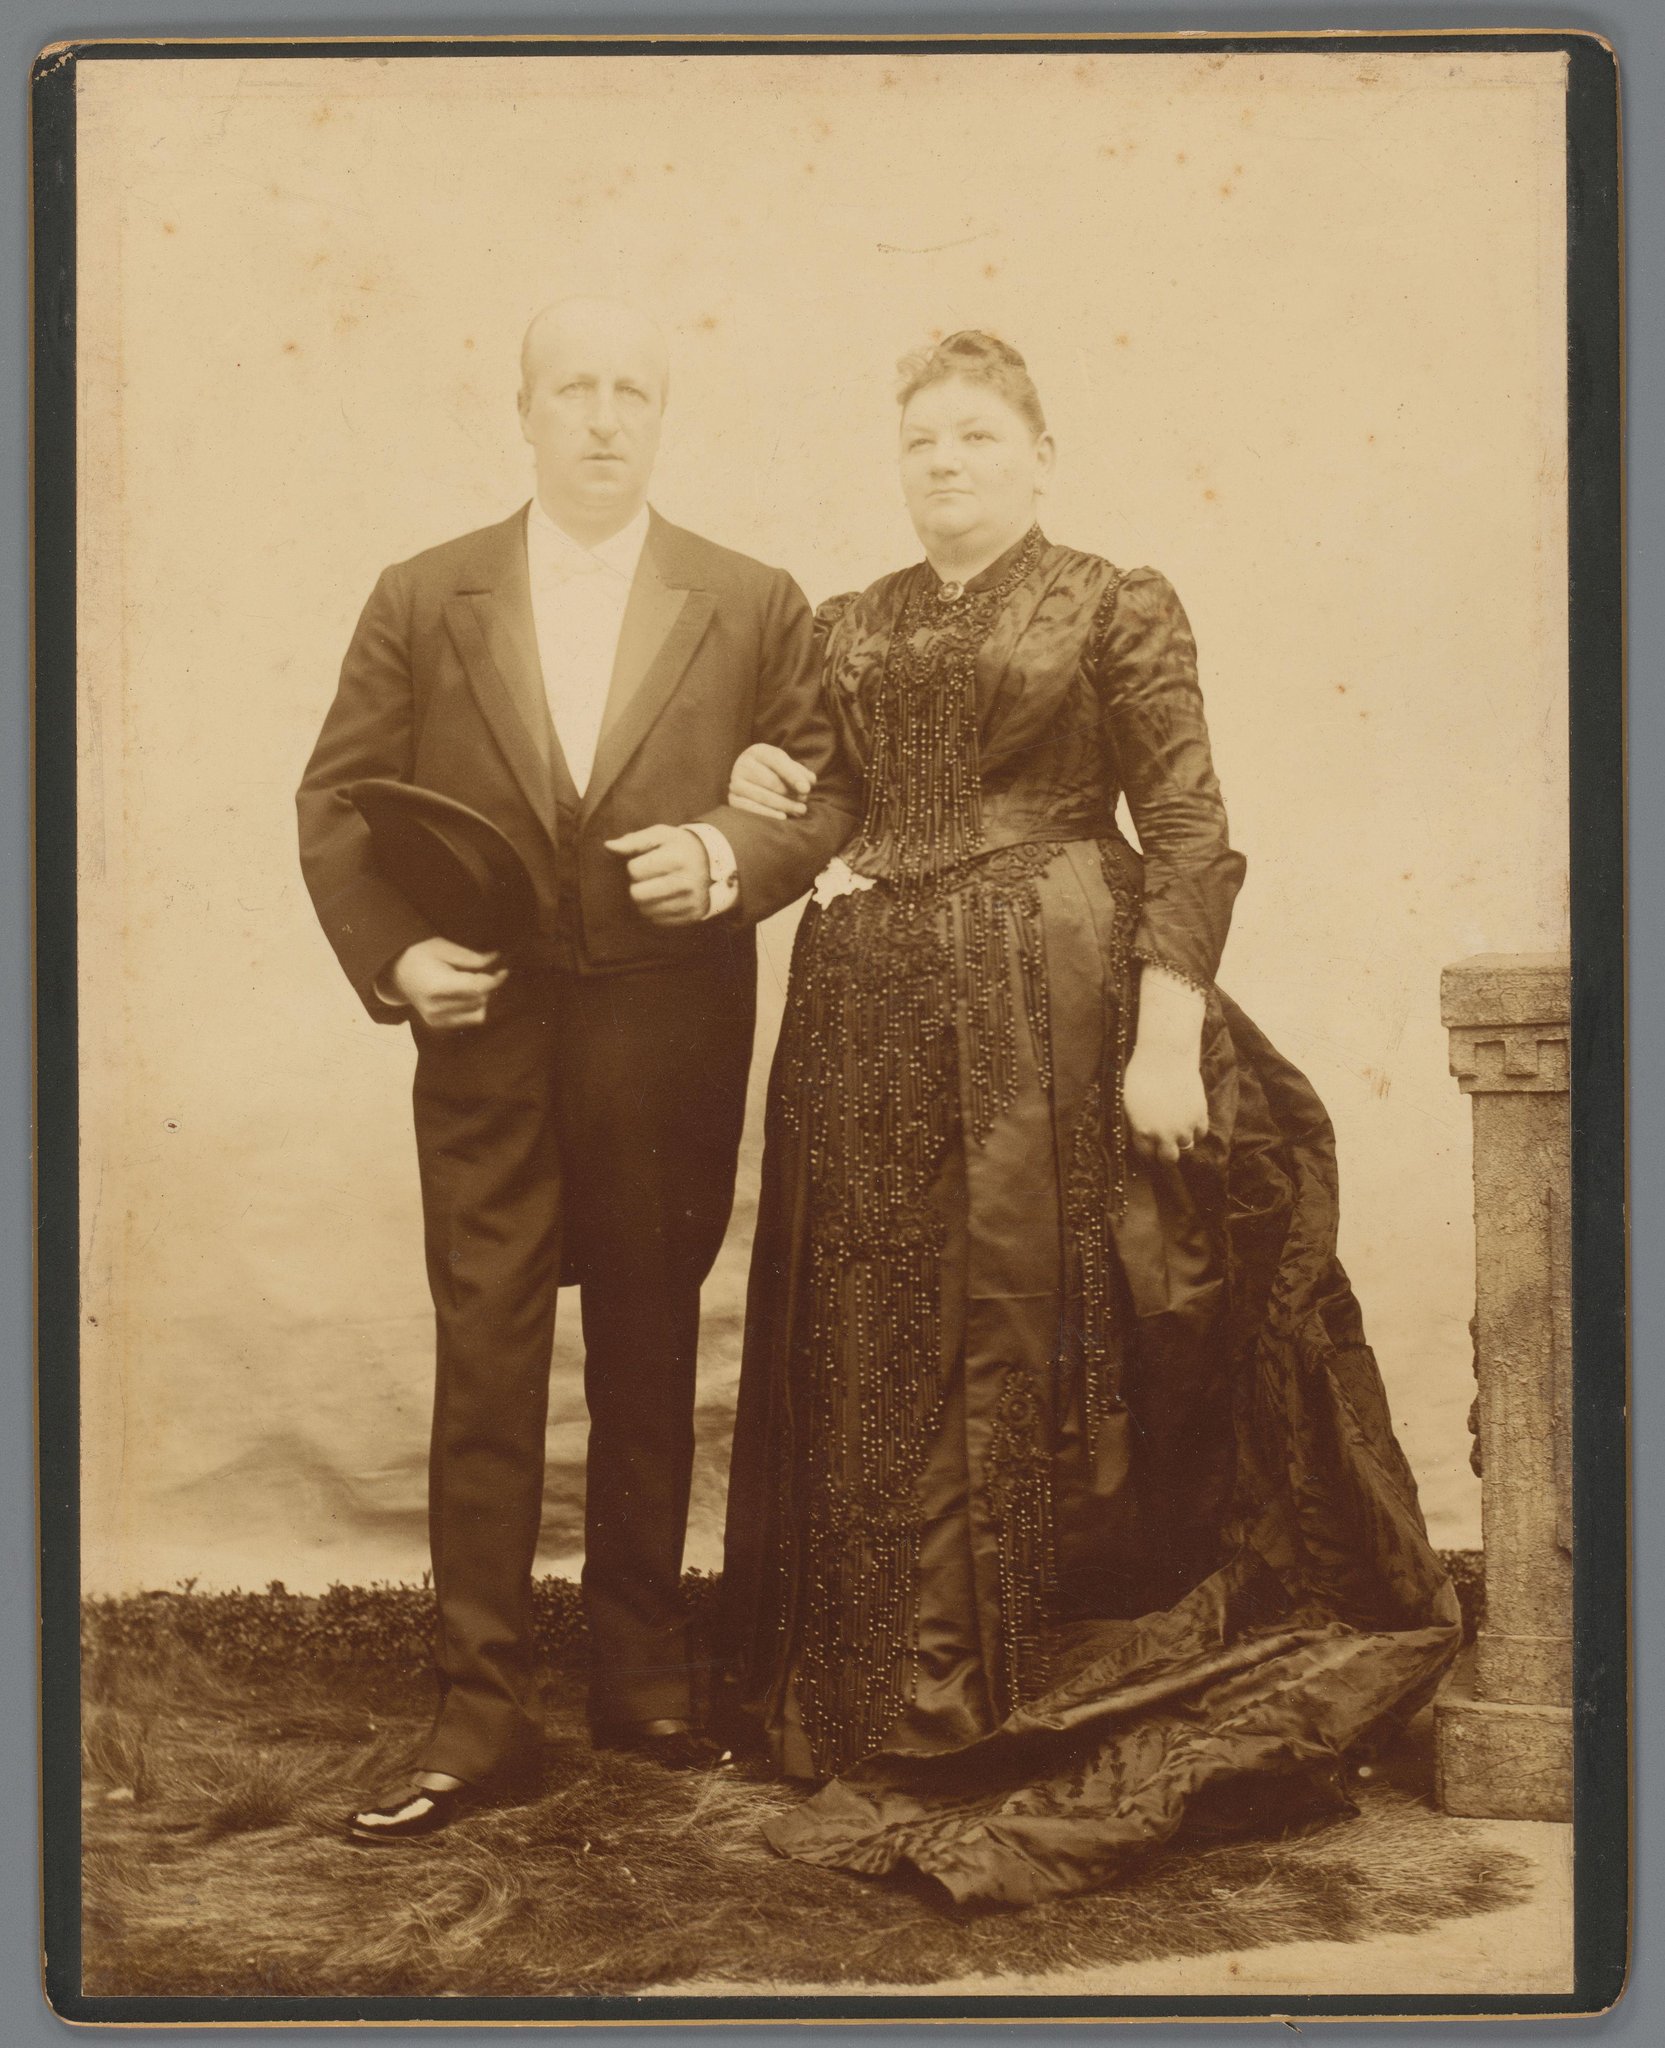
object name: photograph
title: Portret van een onbekende man en vrouw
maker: Anonymous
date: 1882-1920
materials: cardboard, photographic support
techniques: gelatin silver print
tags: adult woman, adult man, anonymous historical persons portrayed in a double portrait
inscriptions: inscription: ‘Com/ 1261H’